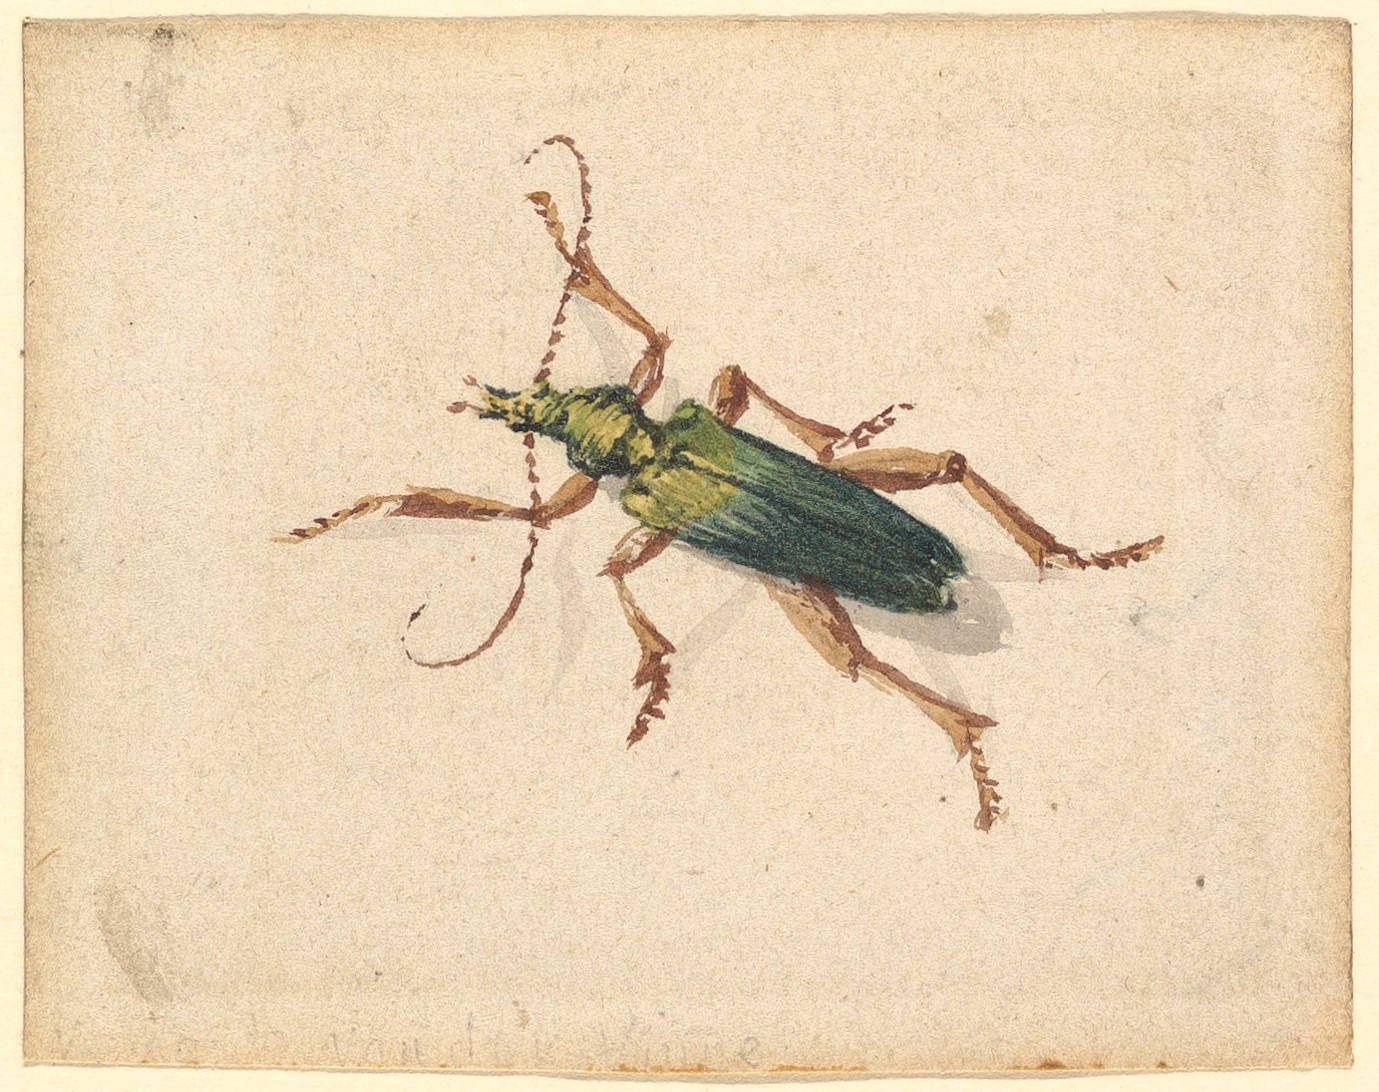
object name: drawing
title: Green Beetle with Brown Legs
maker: vincent laurensz van der vinne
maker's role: artist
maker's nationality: dutch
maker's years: 1628-1702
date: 1667-1700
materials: watercolor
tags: insects